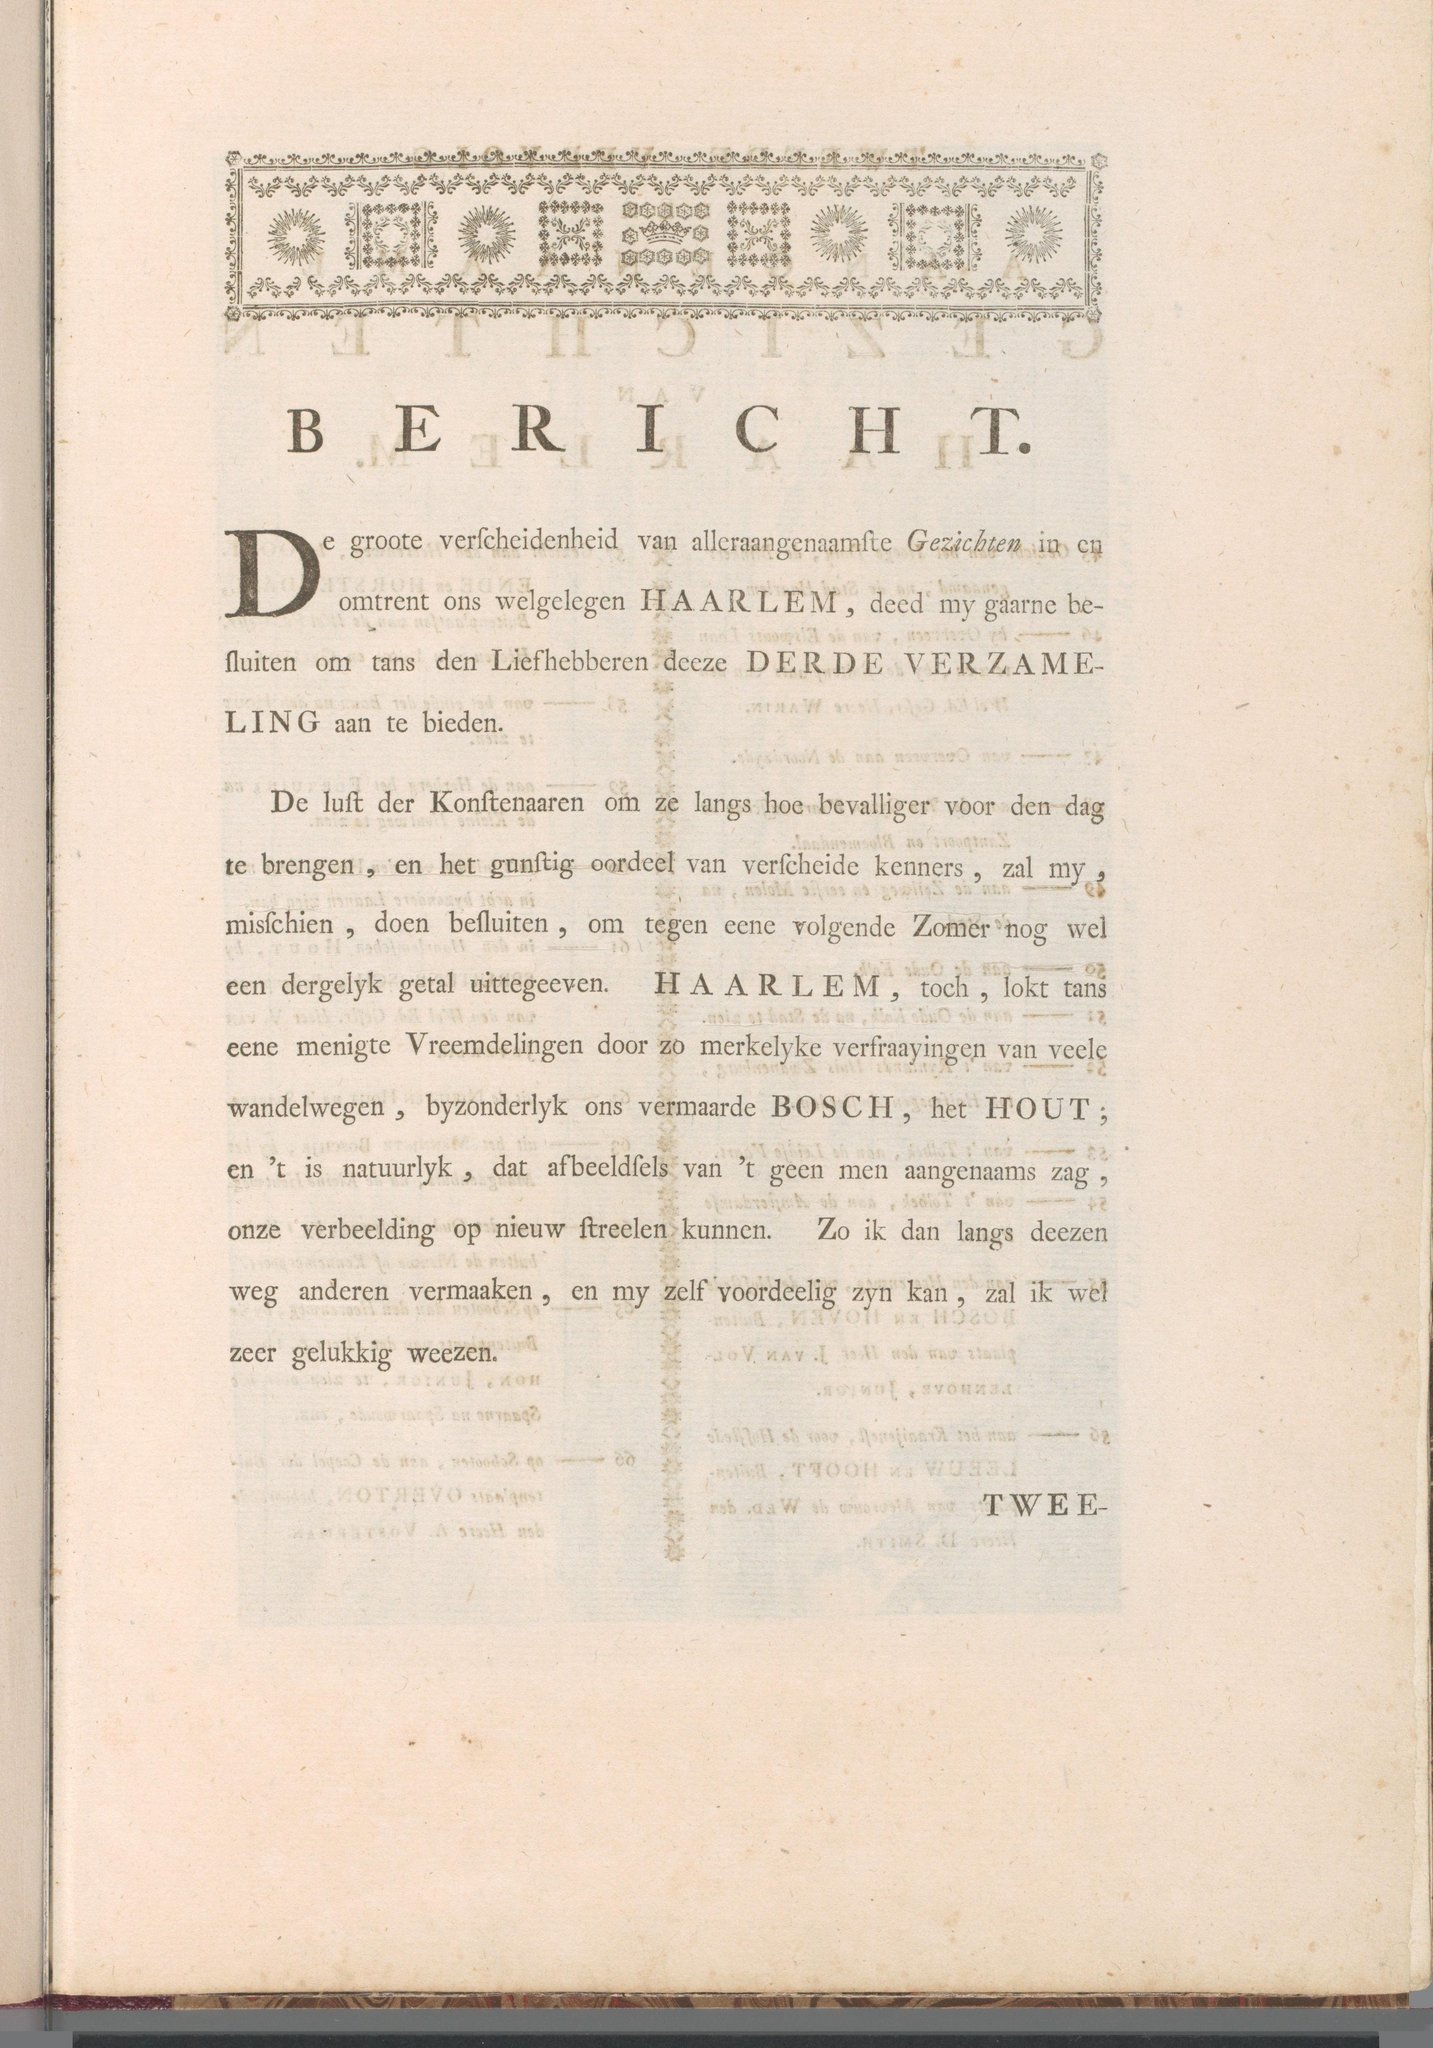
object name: text sheet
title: Tekstblad uit: Tweede vervolg van twee- en twintig aangenaame gezichten in de vermakelyke landsdouwen van Haarlem, nieuwlings naar 't leven getekend door de beroemde konstenaars H. Spilman en C.V. Noorde, 1763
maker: jan bosch (uitgever)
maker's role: publisher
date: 1763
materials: paper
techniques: letterpress printing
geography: haarlem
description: Tekstblad in: Tweede vervolg van twee-en twintig aangenaame gezichten in de vermakelyke landsdouwen van Haarlem. Haarlem: Jan Bosch, 1763.